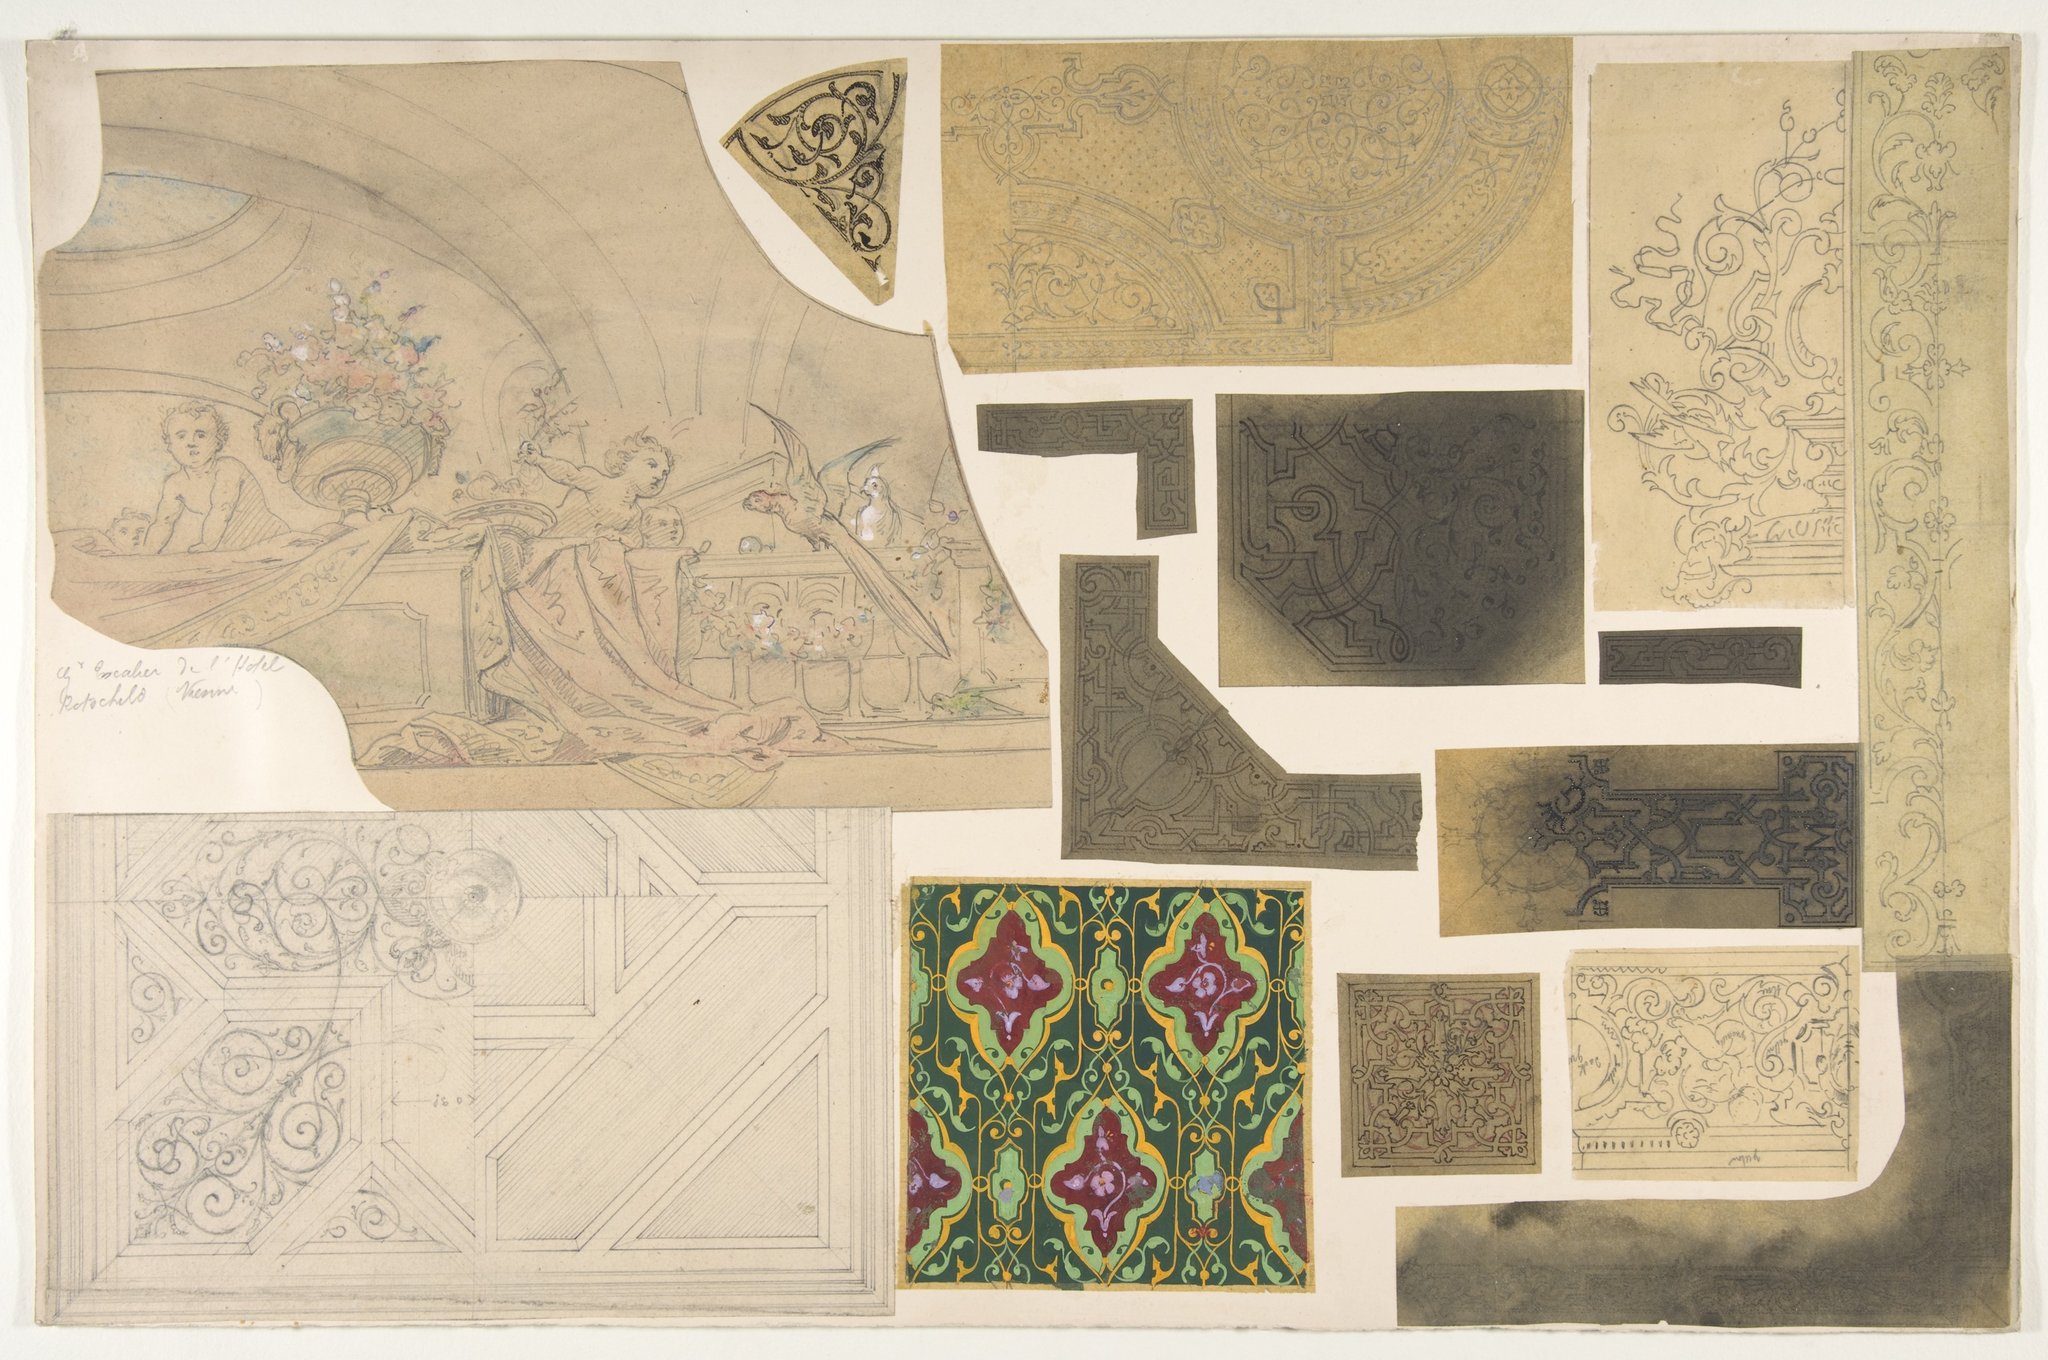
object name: drawing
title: Fifteen Sketches for Ceiling and Cove Designs, Hôtel Rothschild, Vienna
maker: jules-edmond-charles lachaise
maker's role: artist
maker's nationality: french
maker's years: 1897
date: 1851-1900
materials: gouache, graphite, ink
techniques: pen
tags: human figures,birds,architecture,ornament